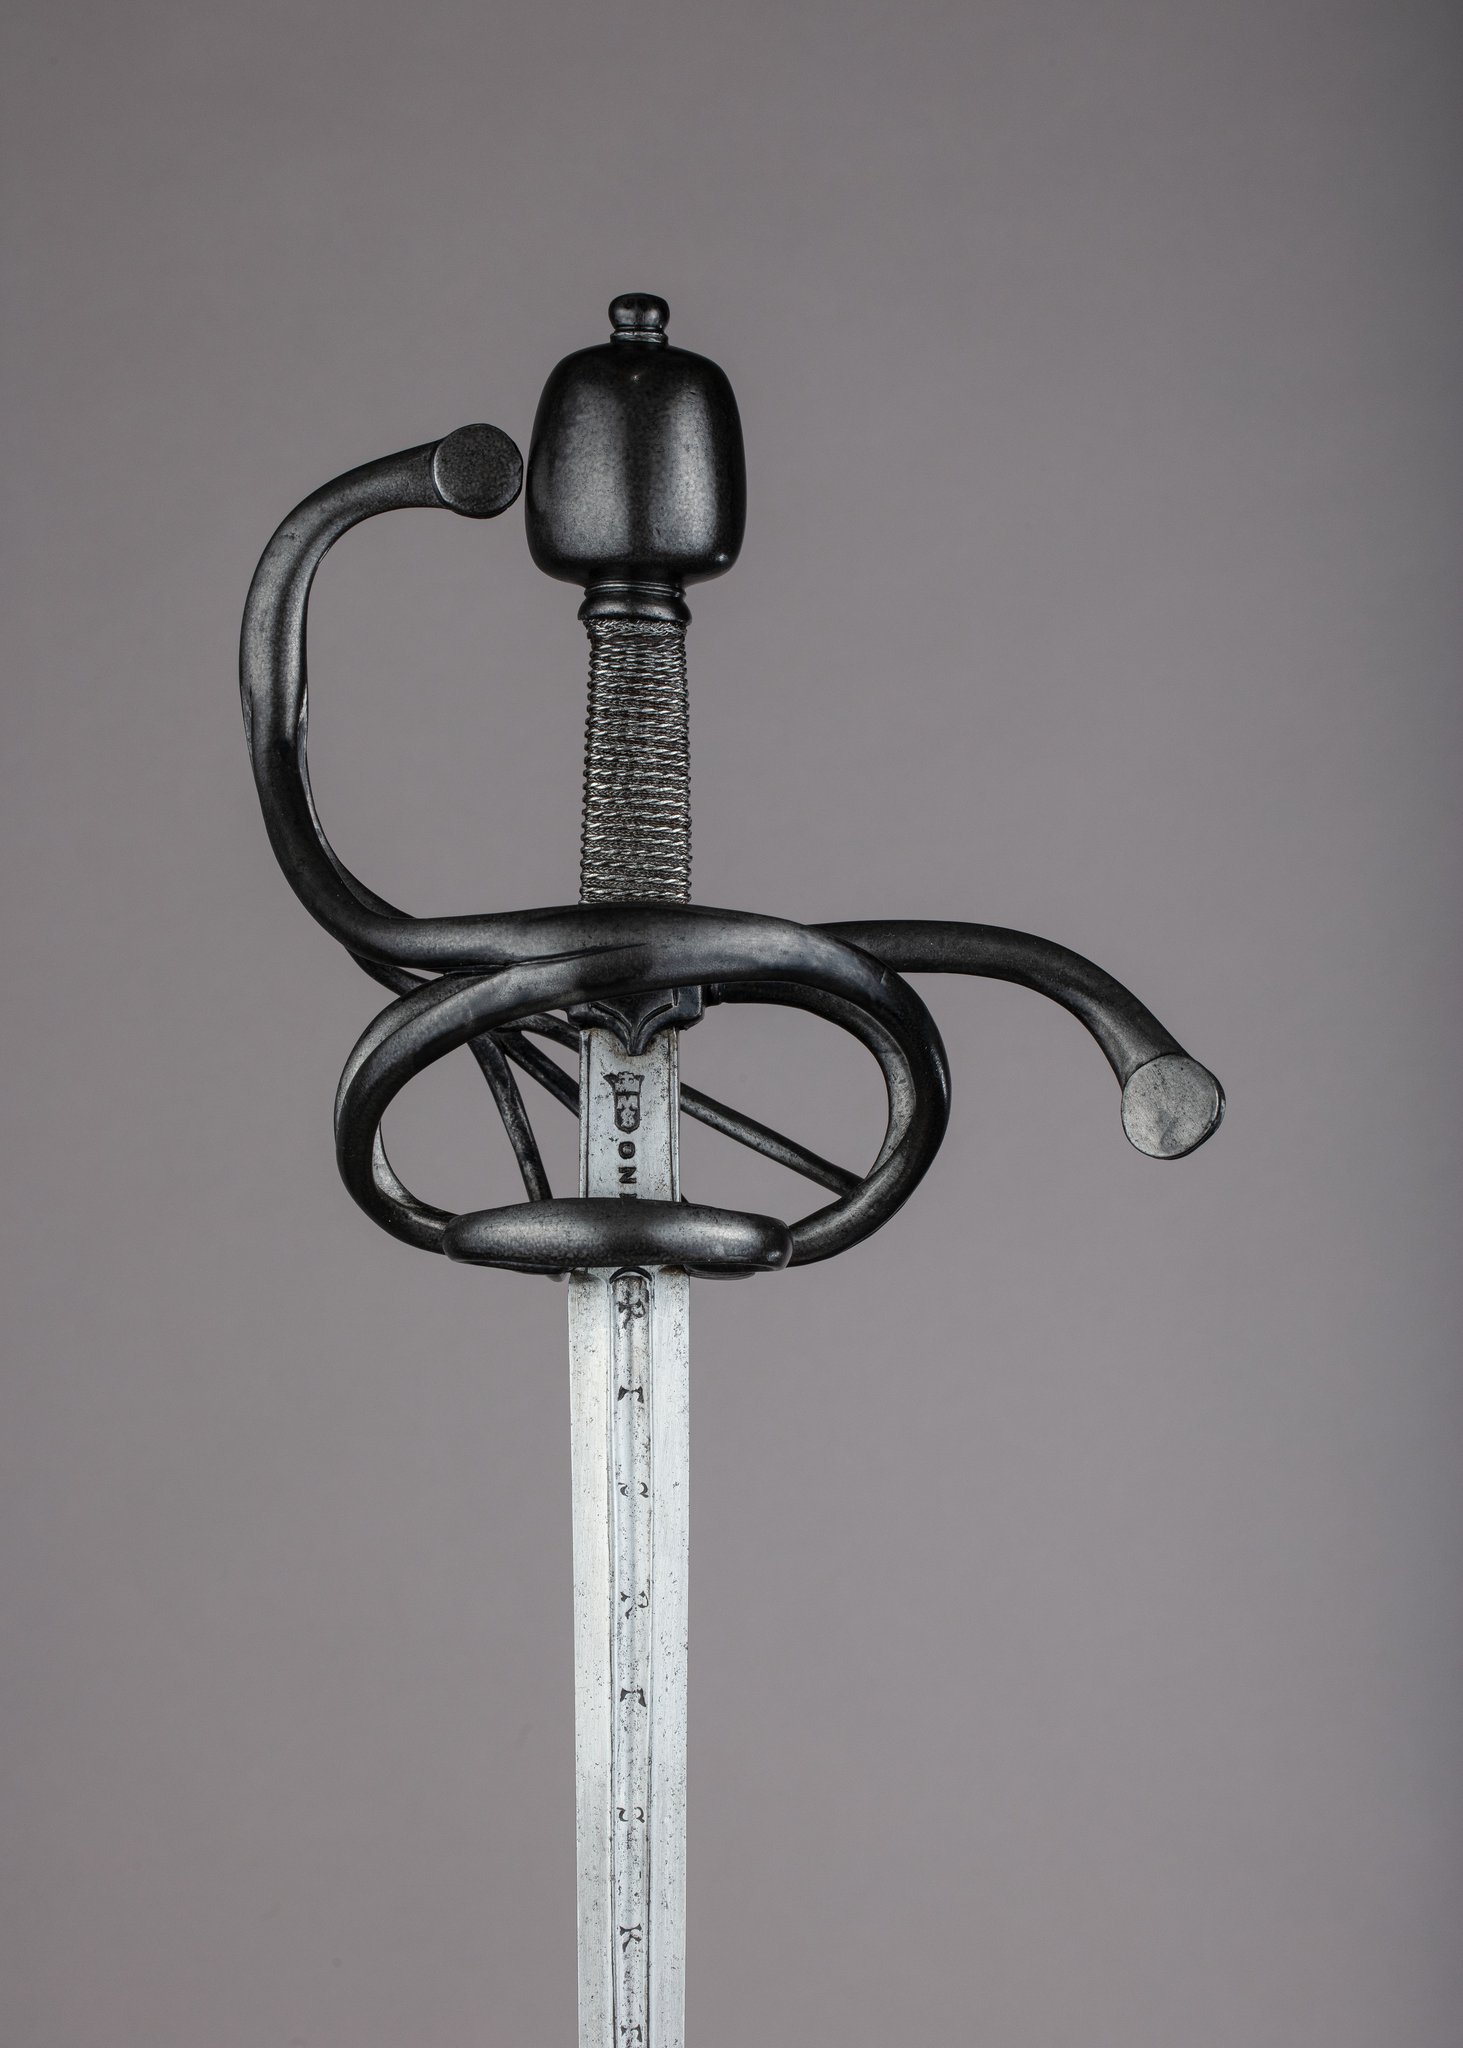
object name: rapier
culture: hilt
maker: pietro caino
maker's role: bladesmith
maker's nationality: italian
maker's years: 1550-1600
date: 1567-1600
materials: iron, steel, wood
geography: germany